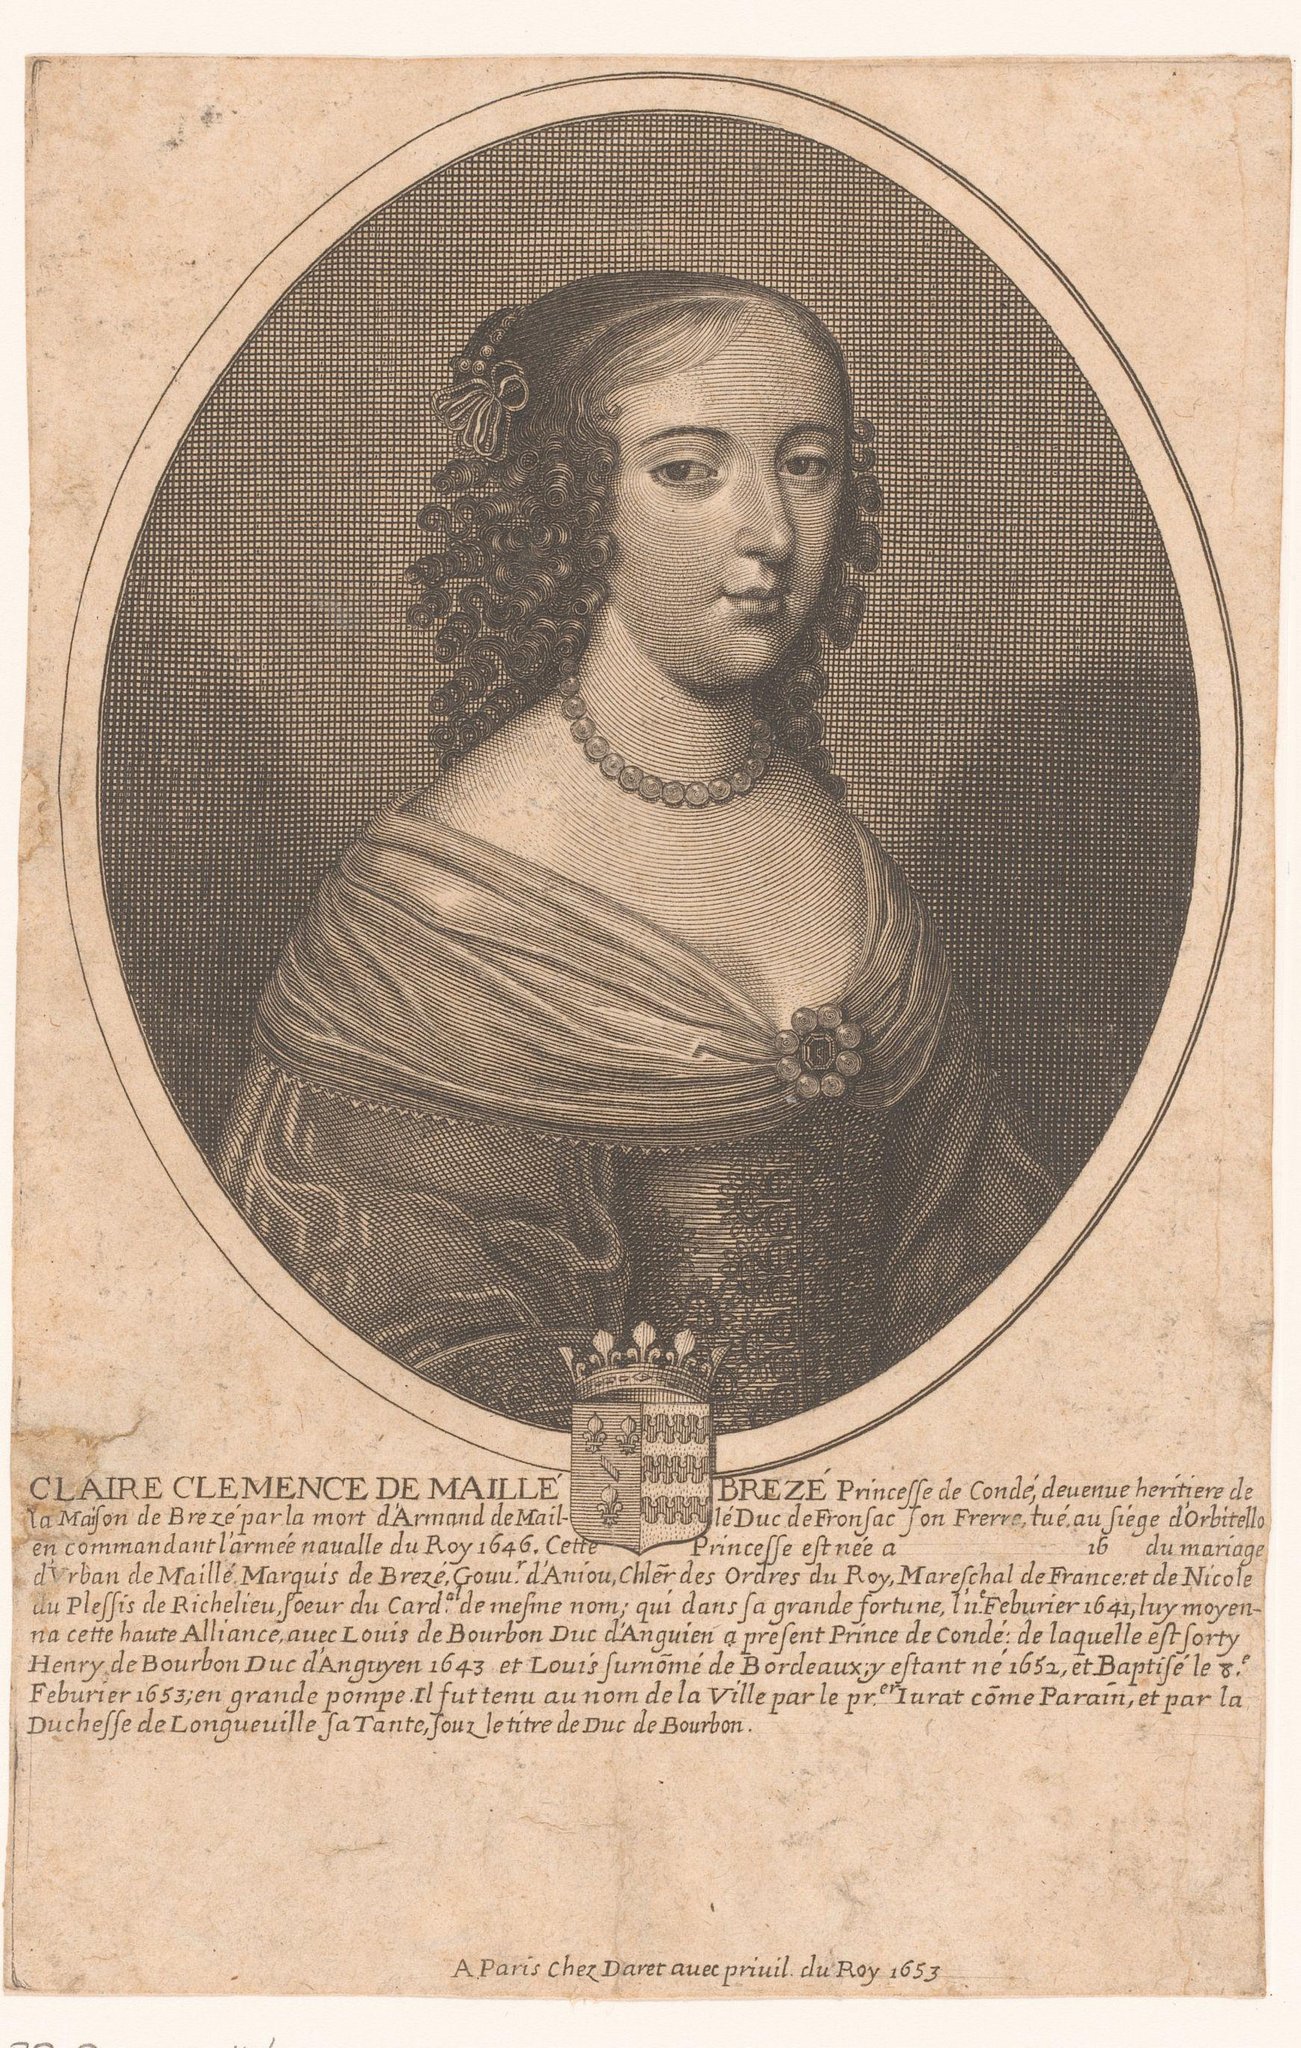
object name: print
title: Portret van Claire Clémence de Maille Brezé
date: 1653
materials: paper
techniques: engraving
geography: france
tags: historical persons, armorial bearing, heraldry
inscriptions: collector's mark: Lugt 2228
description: Maakt deel uit van een serie portretten getiteld 'Tableaux historiques ou sont gravez les Illustres François et Etrangiers de l'un et l'autre sexe (...)', voor het eerst uitgegeven in 1652 door Daret. Een tweede staat werd uitgegeven door Boissevin en een derde door Jollain.